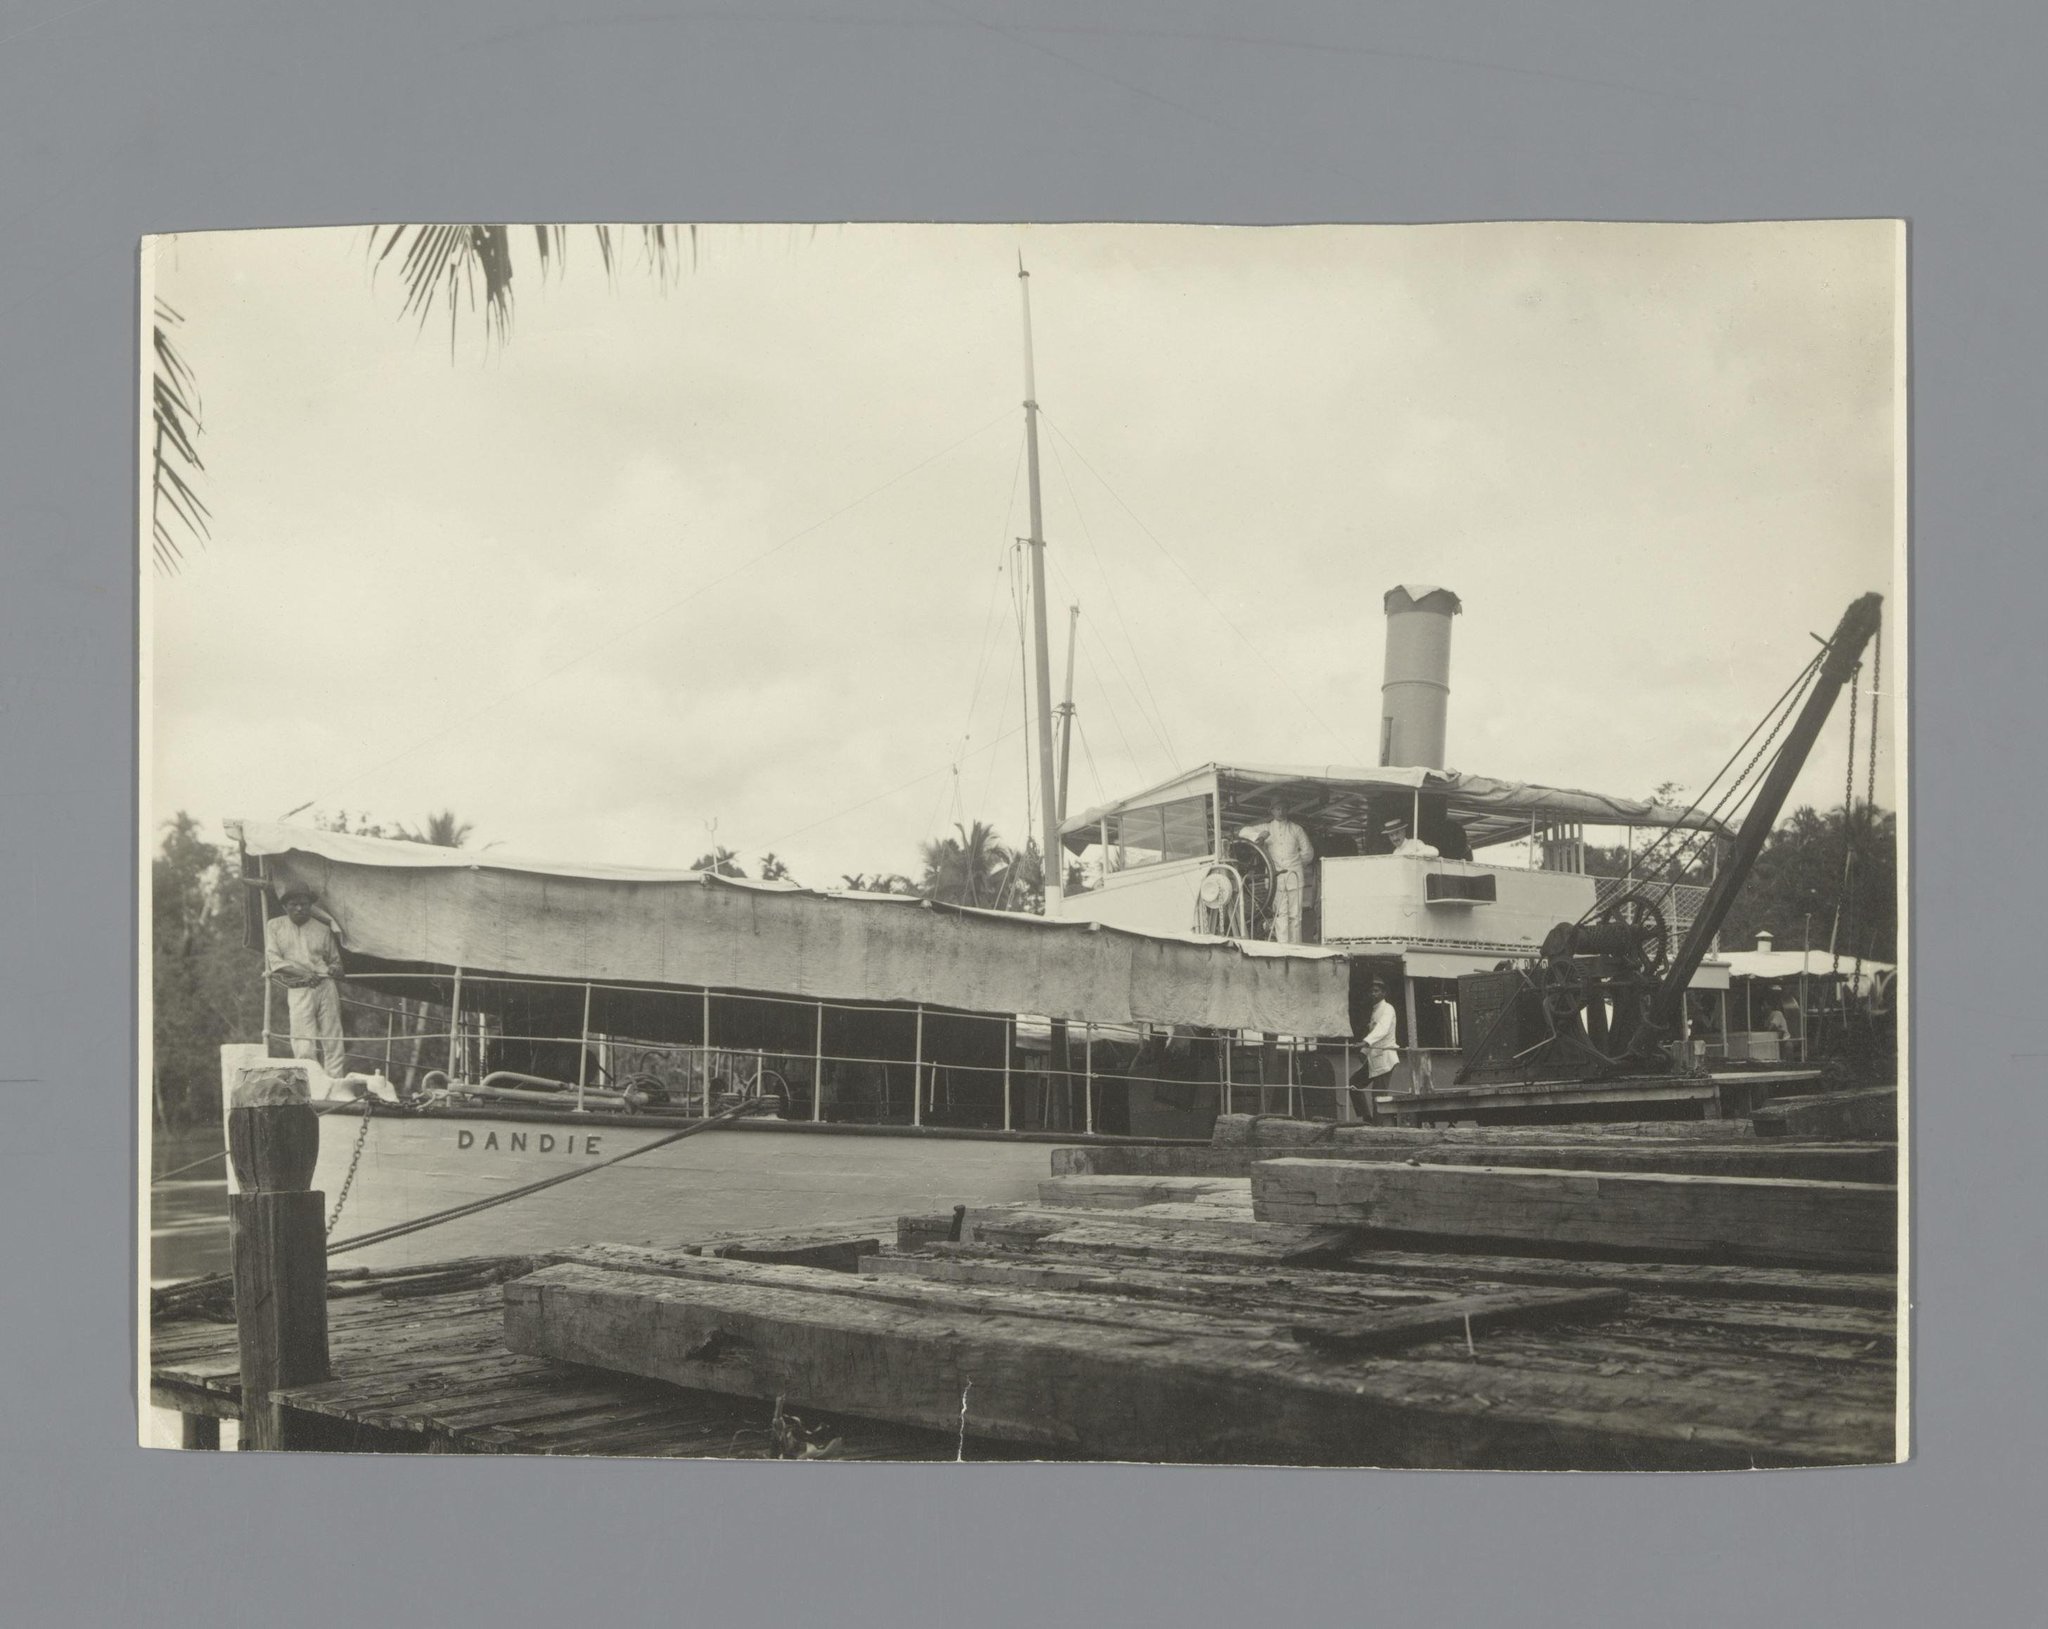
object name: photograph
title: Stoomschip de Dandie van Paul Sandel bij de eerste vaart, Sumatra 1905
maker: Anonymous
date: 1905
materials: paper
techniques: gelatin silver print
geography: sumatra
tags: paul sandel, steamship, motorship, sumatra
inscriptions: inscription: ‘49./ steam launch/ van/ Paul Sandel/ Langkat/ Sumatra/ (1905)/ 44./ mit der "Butterblume"/ Onkel David Sandel’